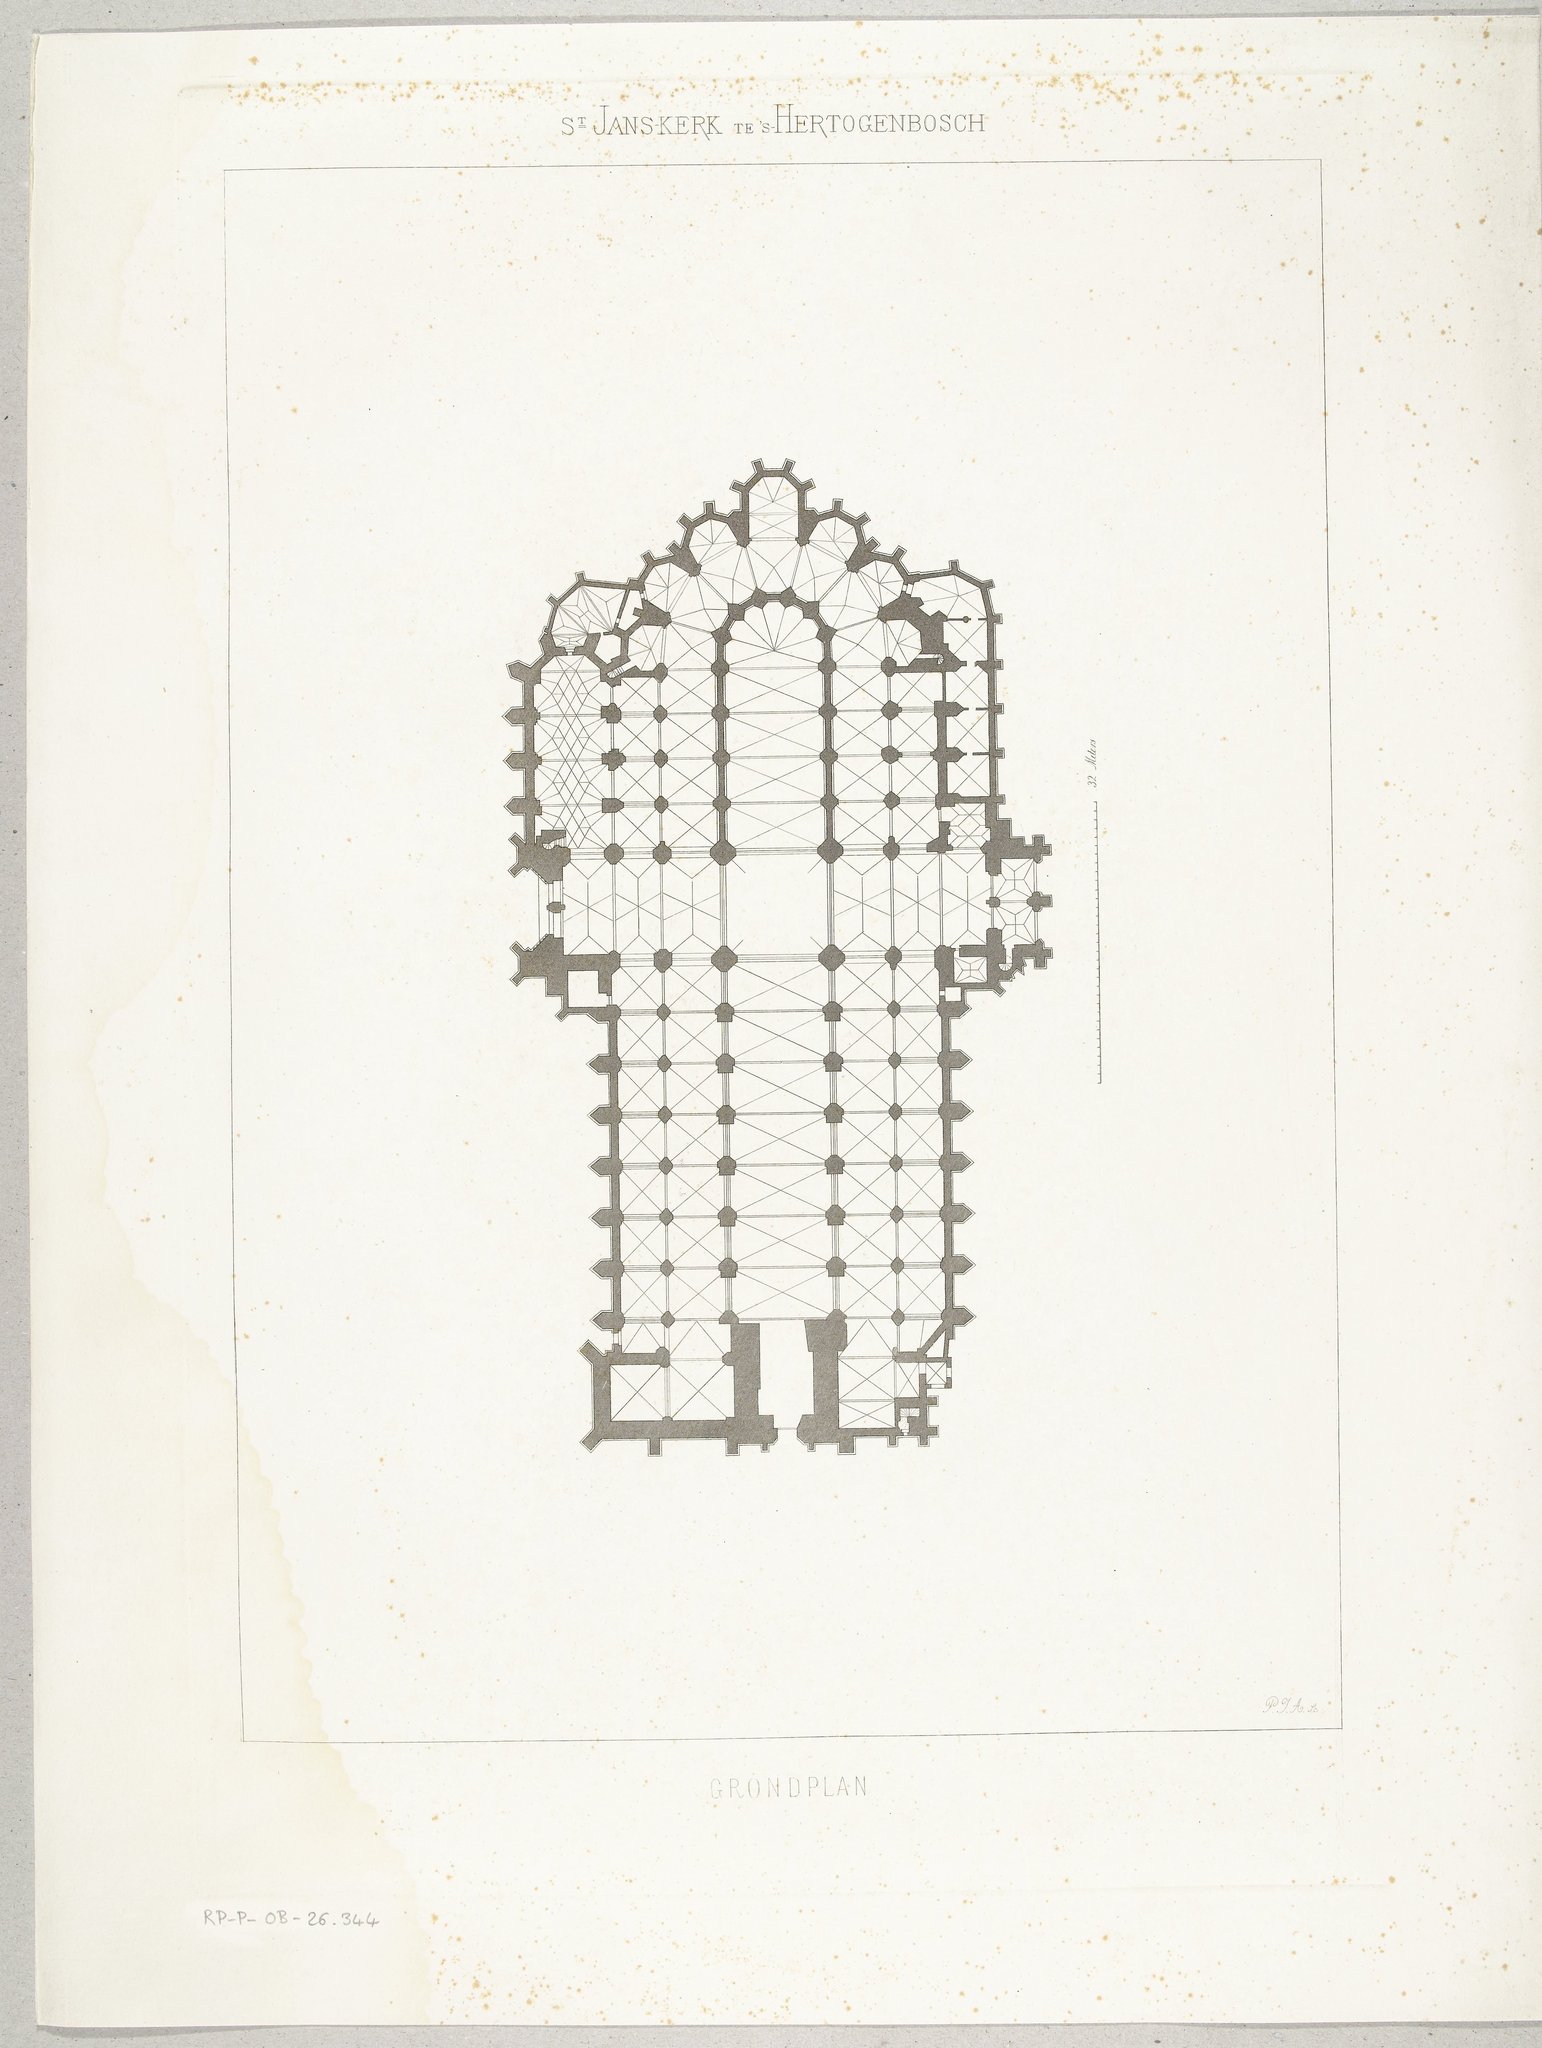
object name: print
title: Grondplan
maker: petrus johannes arendzen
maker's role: draughtsman, print maker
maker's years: 1846-1932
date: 1875-1895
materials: paper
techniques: engraving, etching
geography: netherlands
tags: sint-janskathedraal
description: Waarschijnlijk afkomstig uit: J.C.A. Hezenmans, De St. Jans-kerk te 's-Hertogenbosch, uitg. door het Provinciaal Genootschap voor Kunsten en Wetenschappen in Noord-Brabant, 's-Hertogenbosch : Muller, [1895]